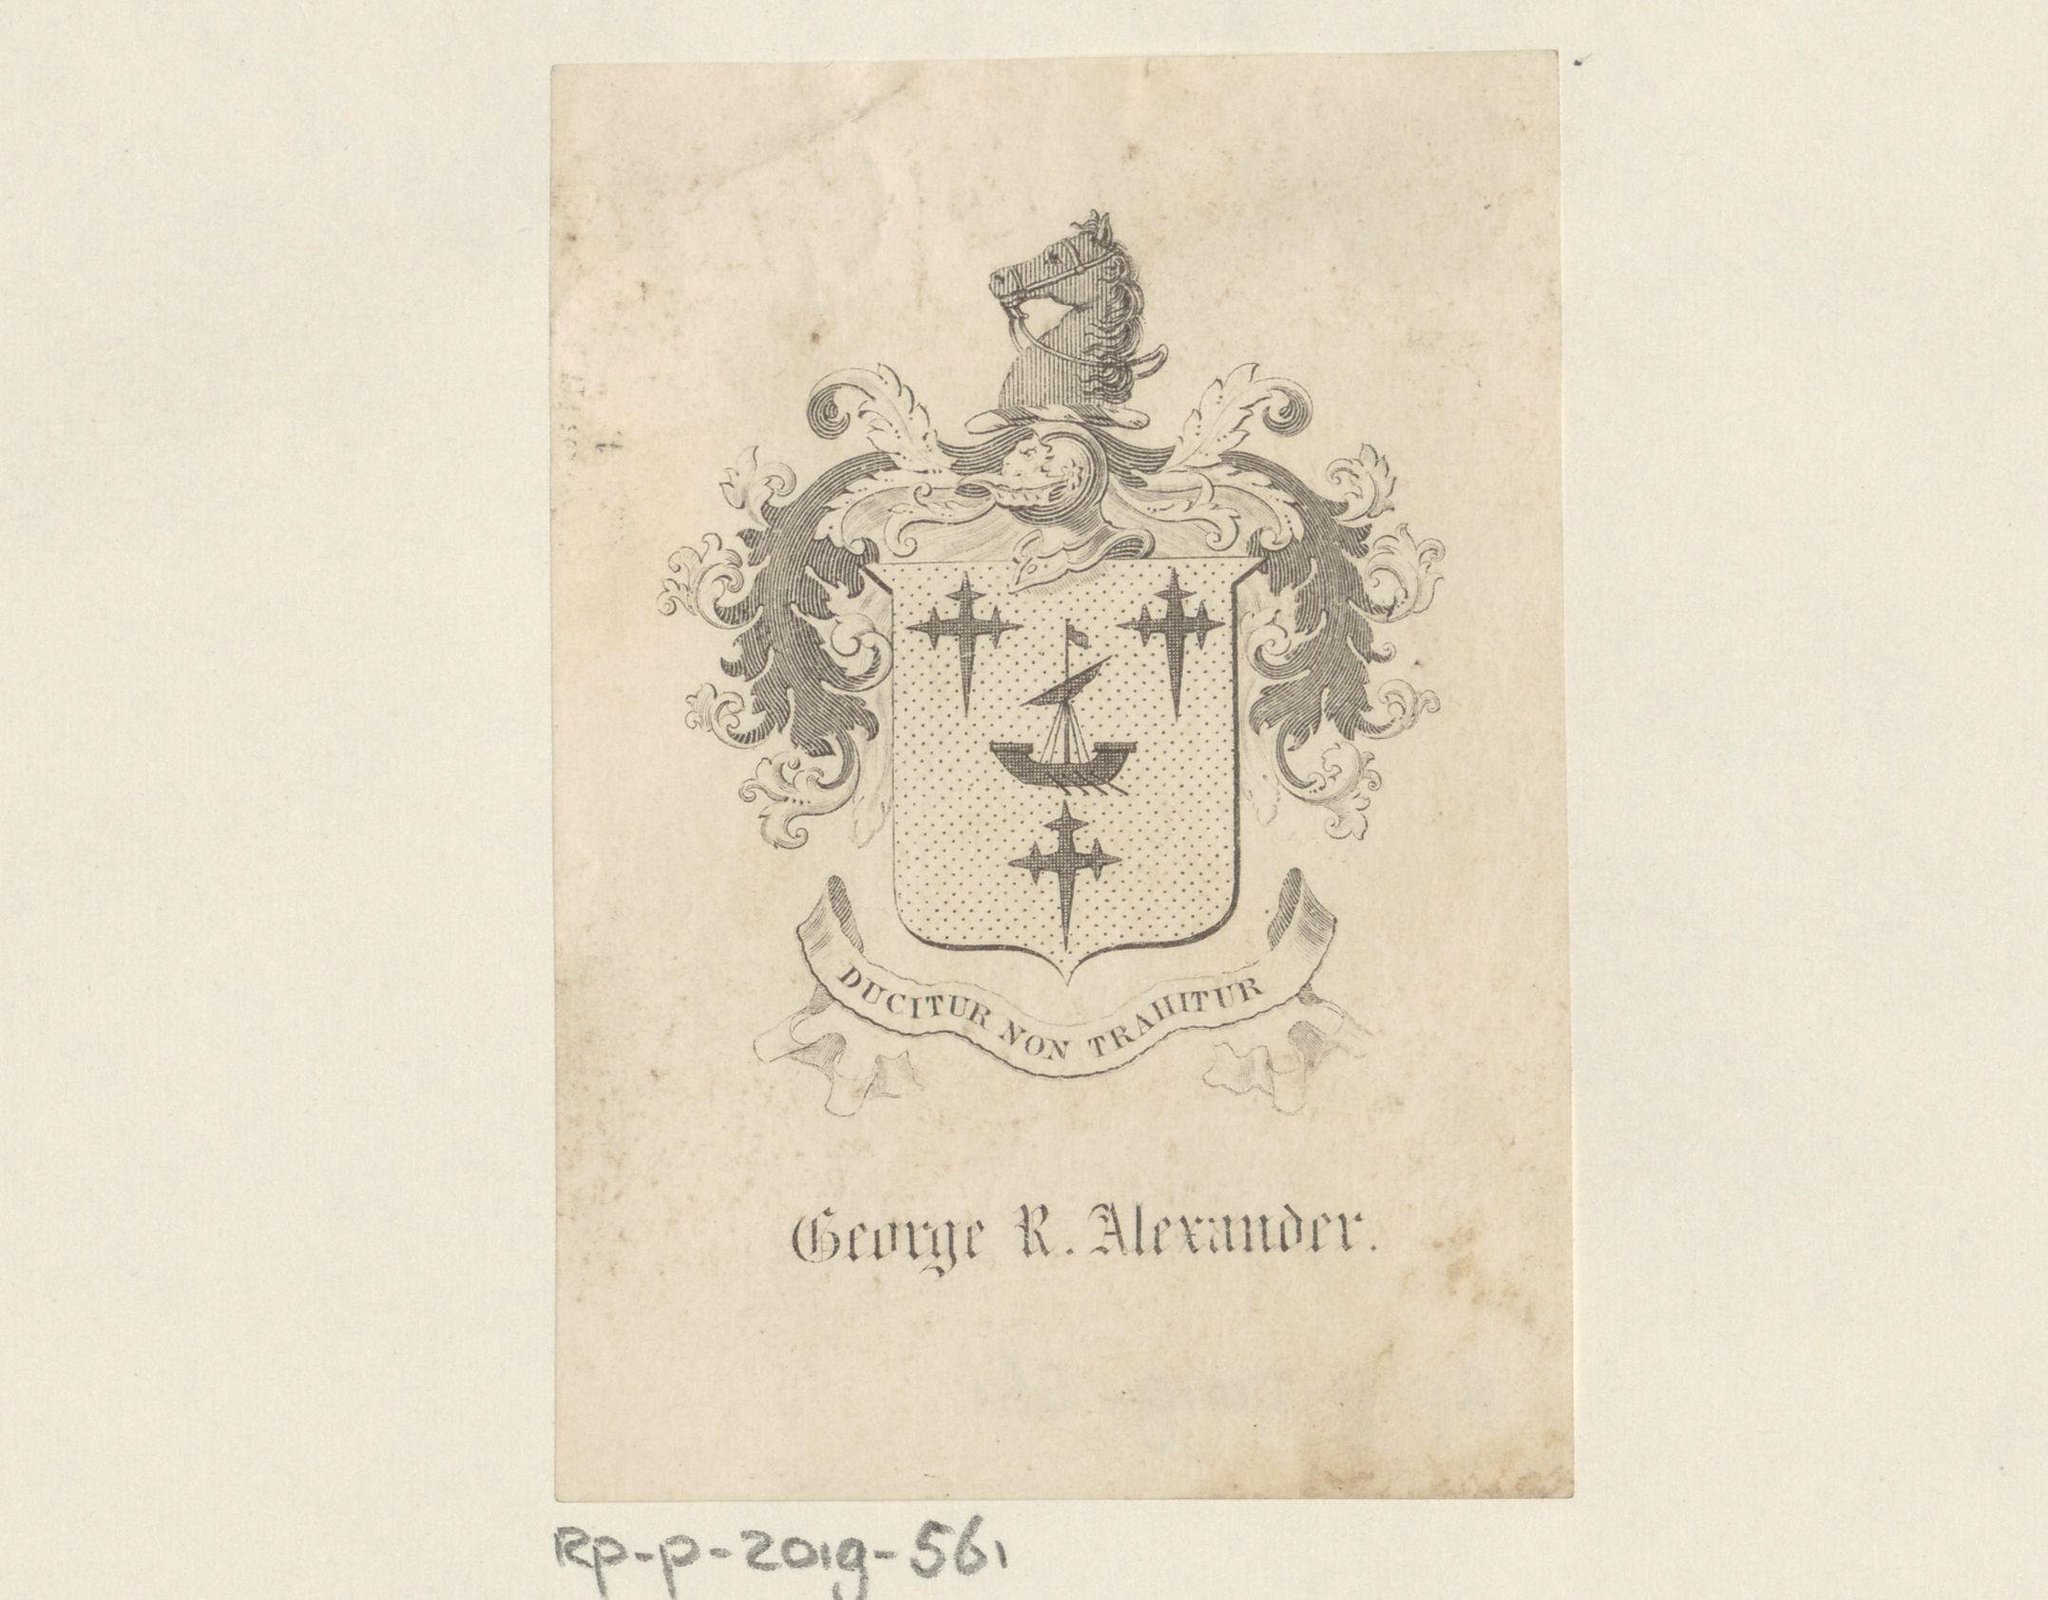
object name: bookplate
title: Ex libris van George R. Alexander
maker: Anonymous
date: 1800-1899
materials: paper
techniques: engraving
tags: armorial bearing, heraldry